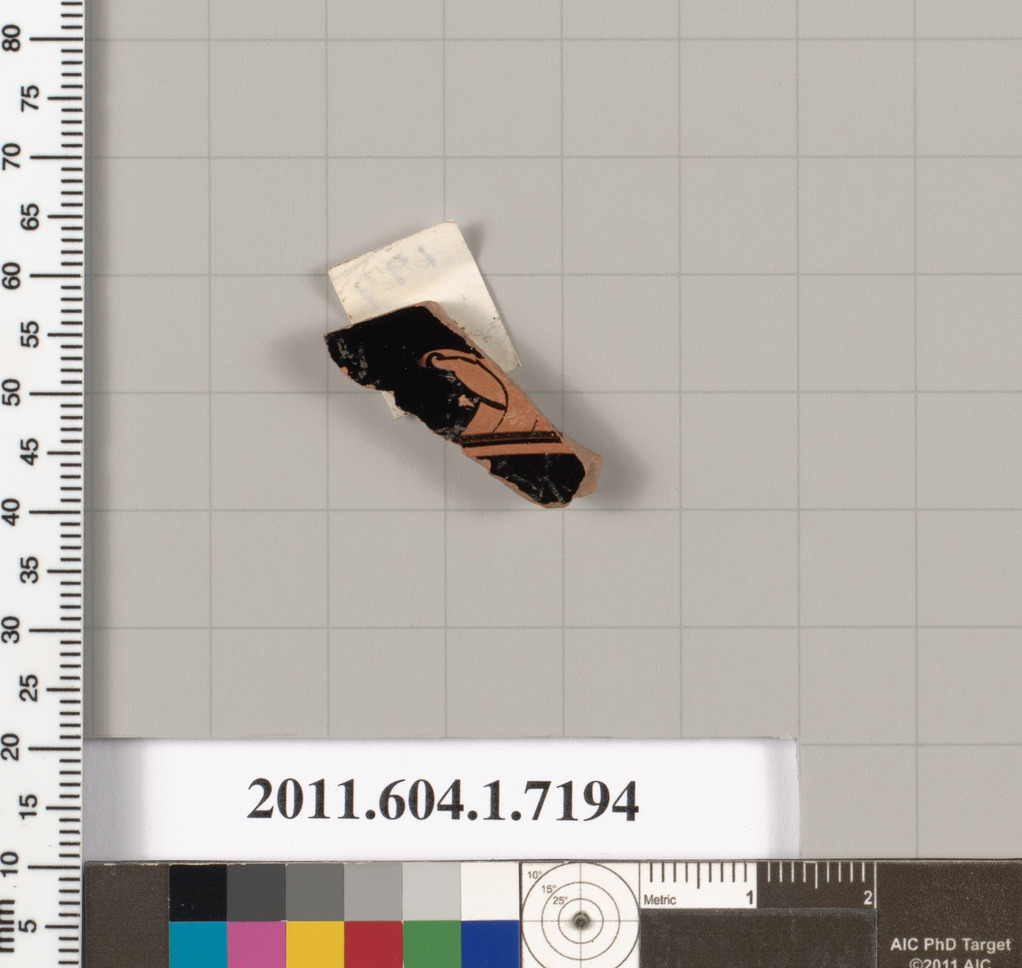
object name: kylix fragment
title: Terracotta fragment of a kylix (drinking cup)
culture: greek, attic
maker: makron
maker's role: artist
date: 500-480 BCE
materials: terracotta